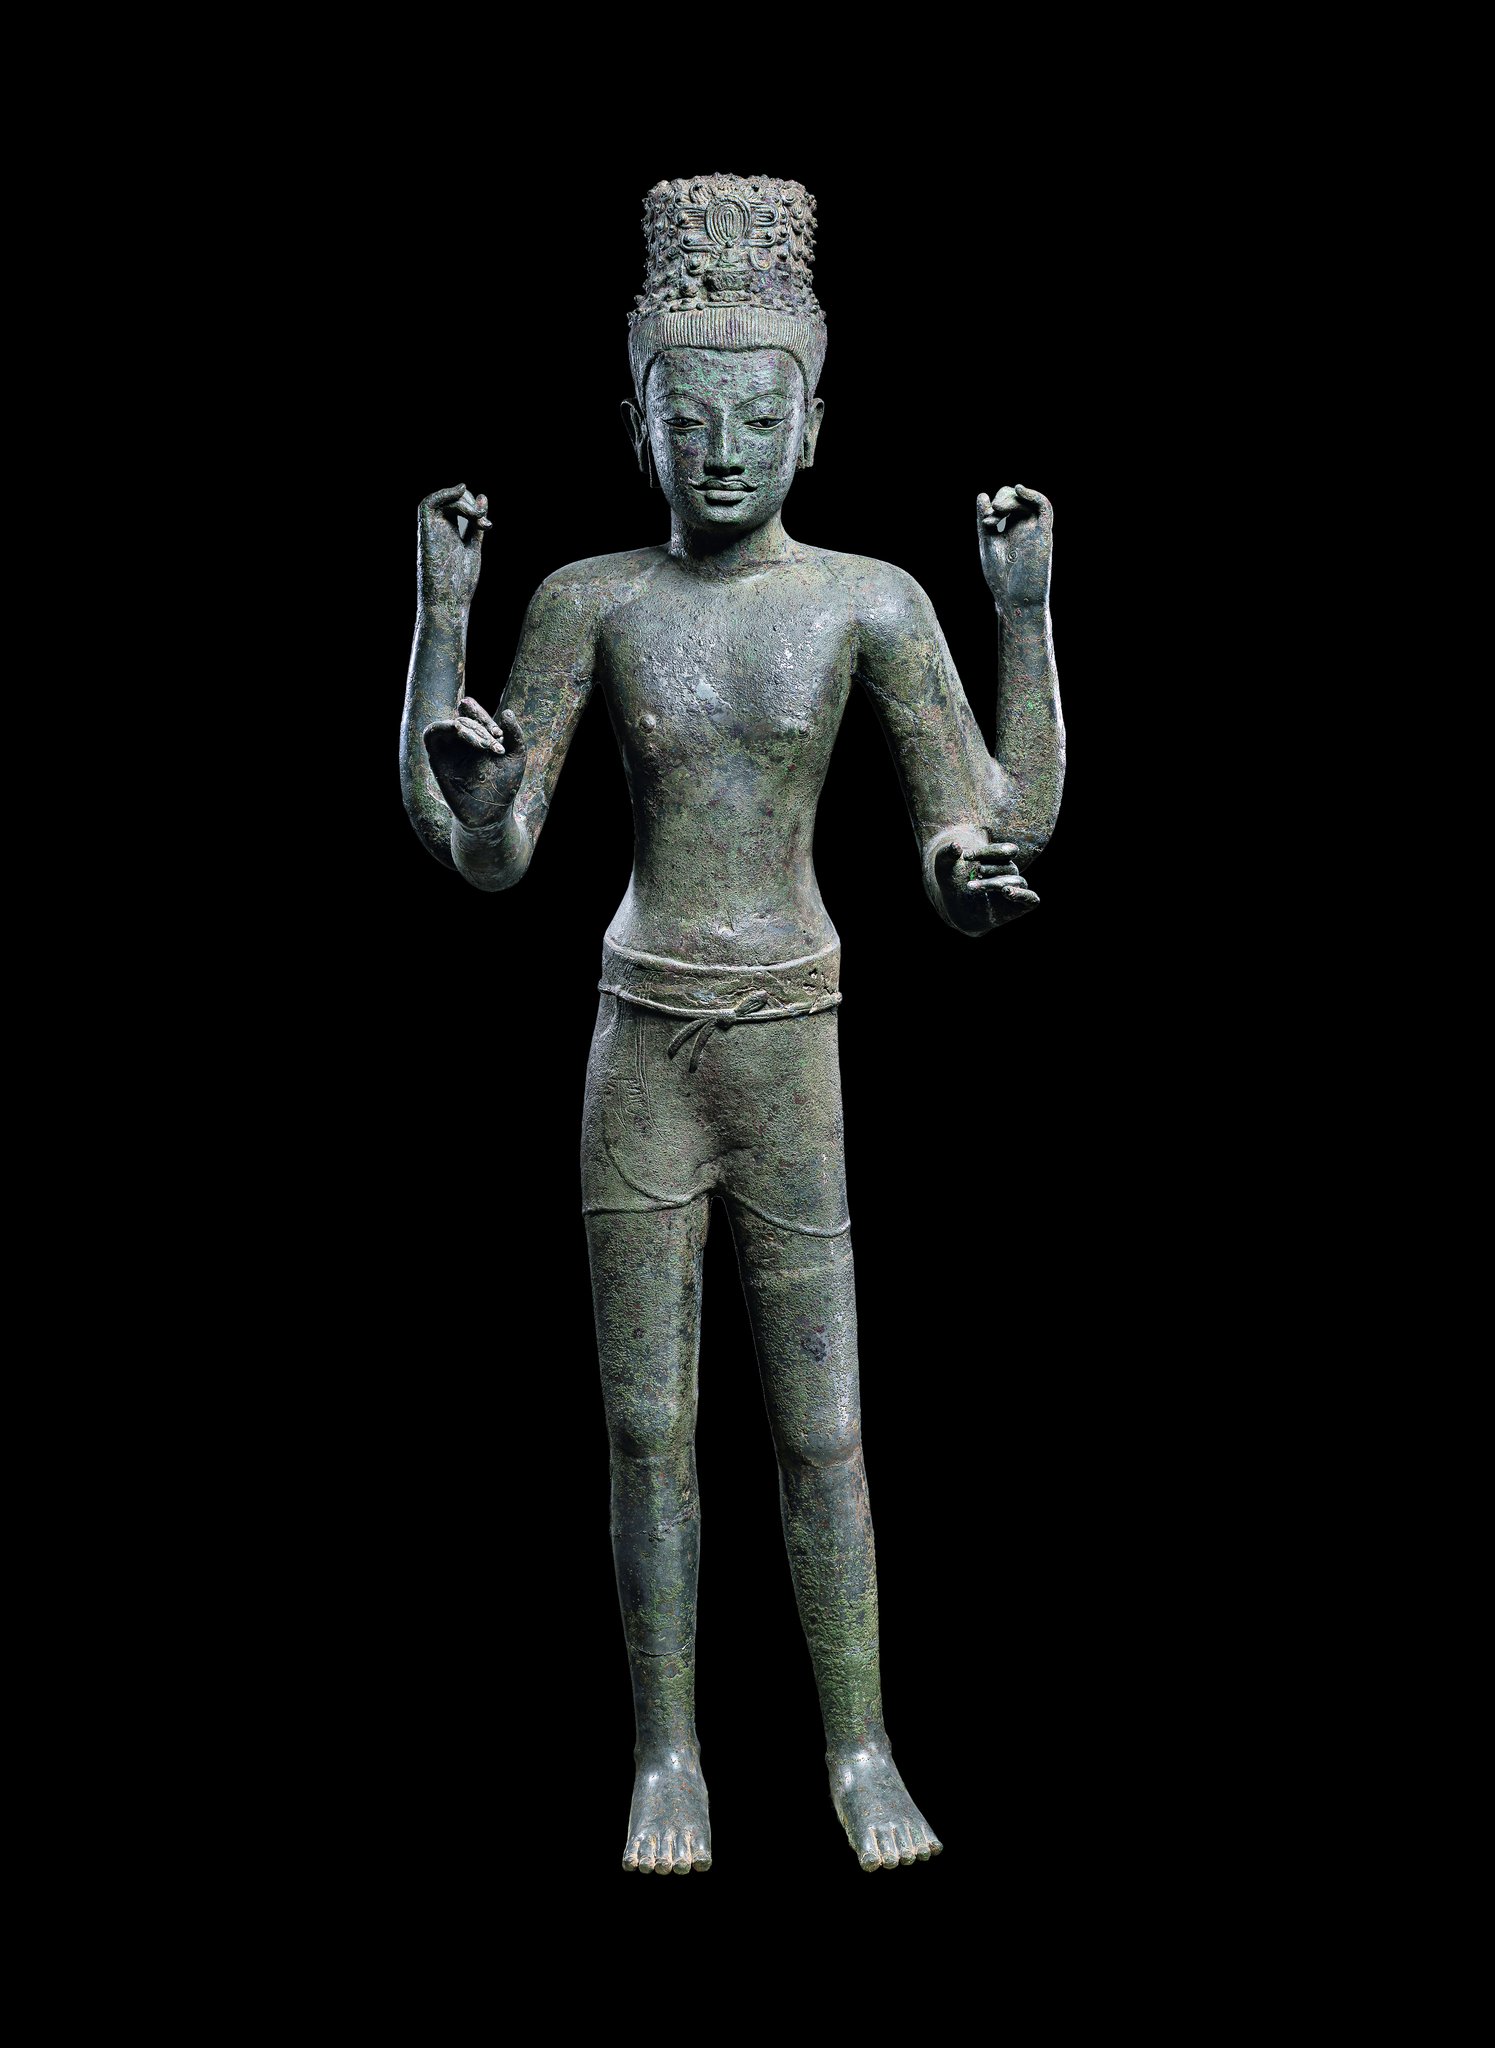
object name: figure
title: Bodhisattva Avalokiteshvara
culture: thailand, buriram province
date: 726-750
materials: copper alloy, glass, obsidian, silver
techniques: inlay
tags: buddhism,avalokiteshvara,bodhisattvas